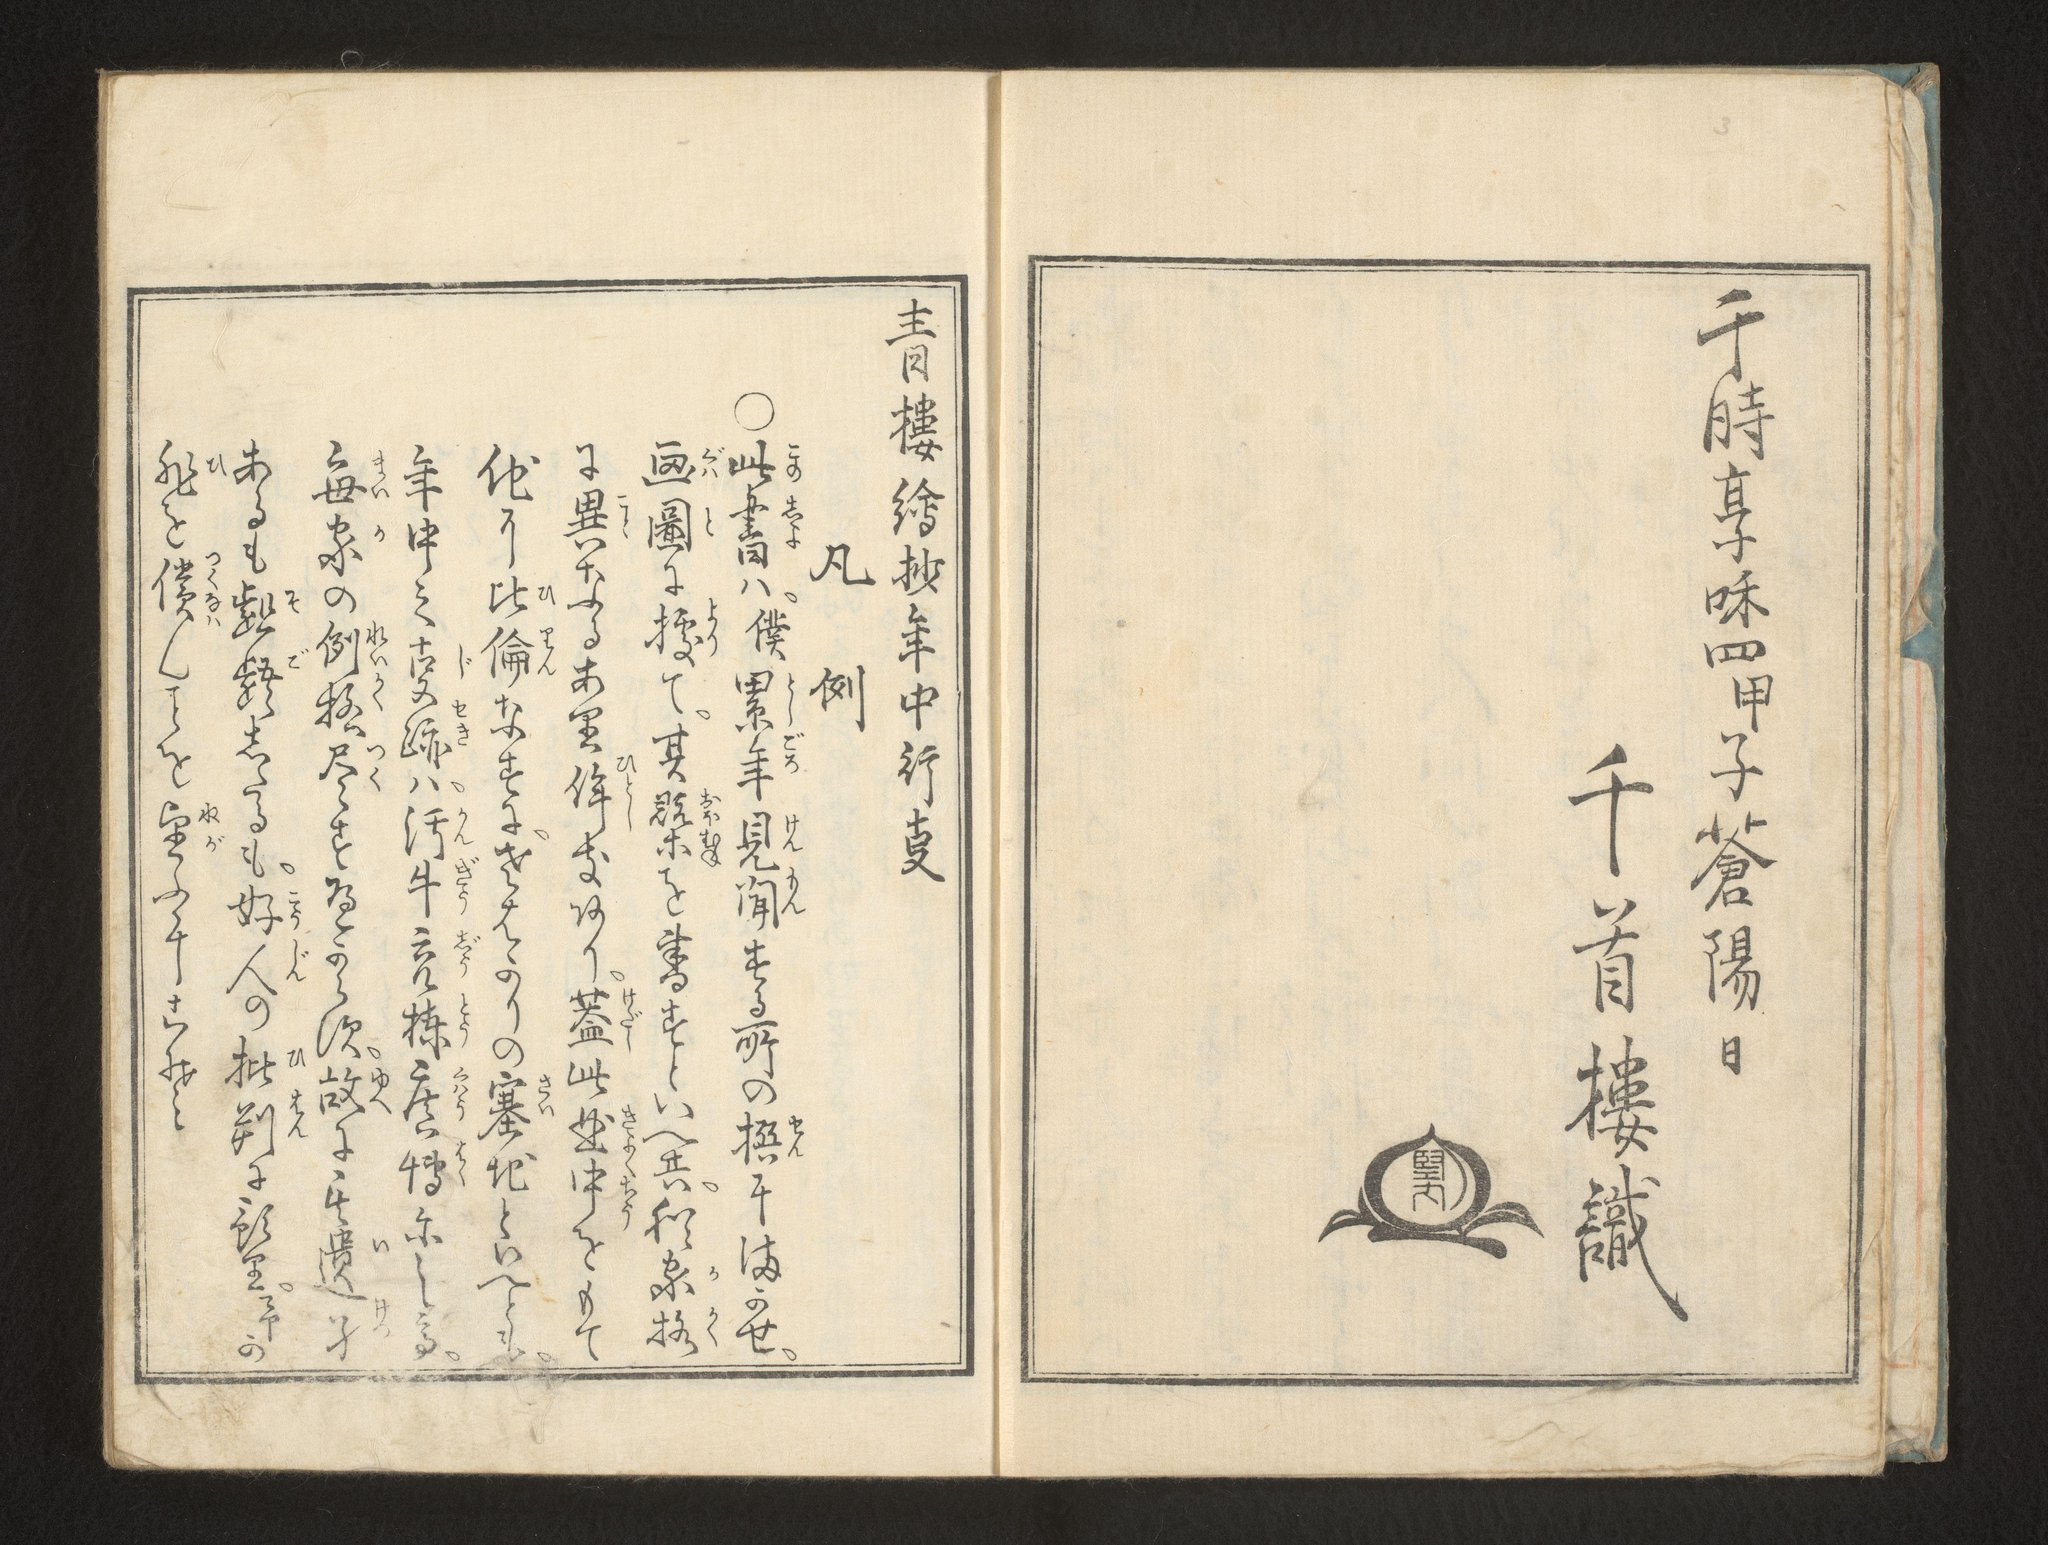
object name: page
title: Inleiding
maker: jippensha ikku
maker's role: schrijver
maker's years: 1765-1831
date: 1804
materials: paper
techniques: woodcut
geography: edo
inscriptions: date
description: Vierde en vijfde tekstpagina van deel één van Utamaro`s boek: Gebeurtenissen in de lusthuizen gedurende het jaar.